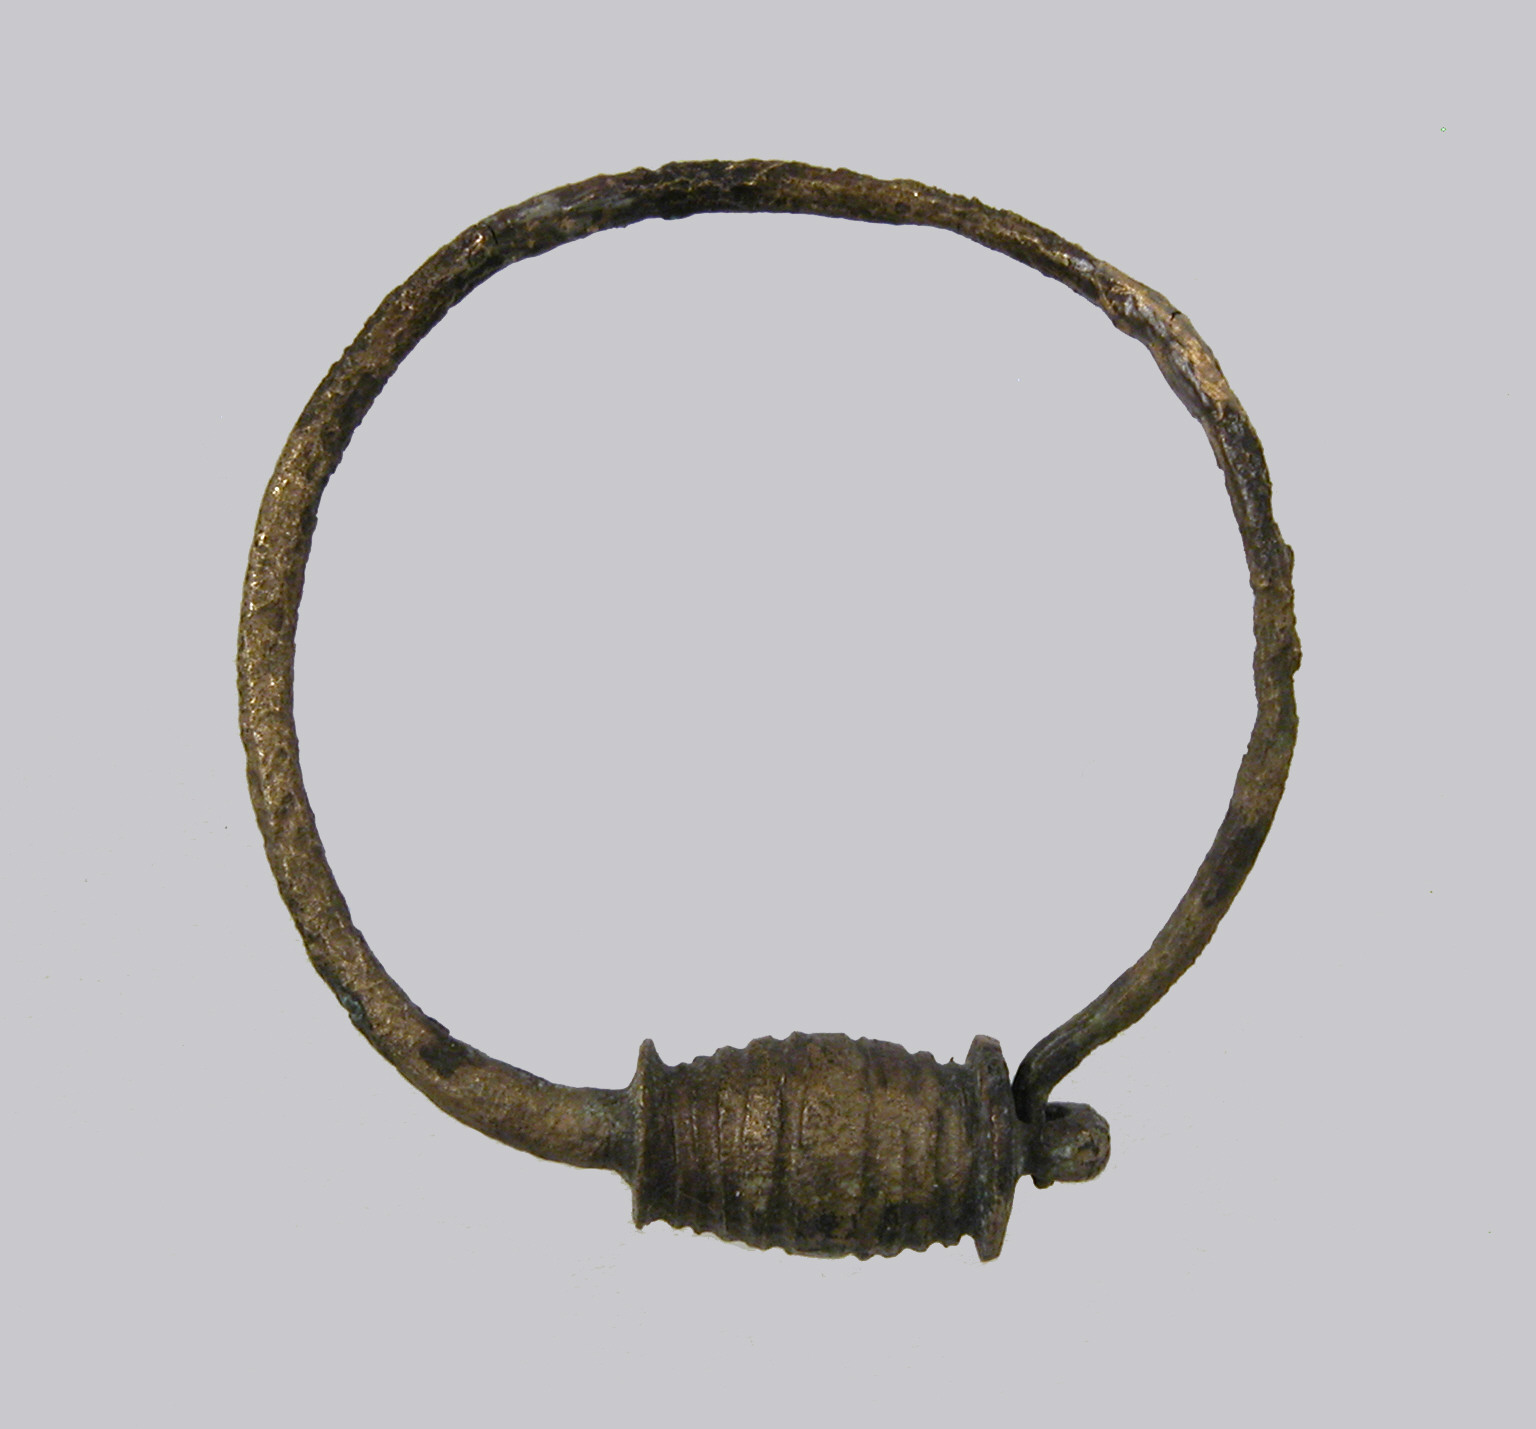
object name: earring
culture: frankish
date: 601-700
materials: copper alloy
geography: germany